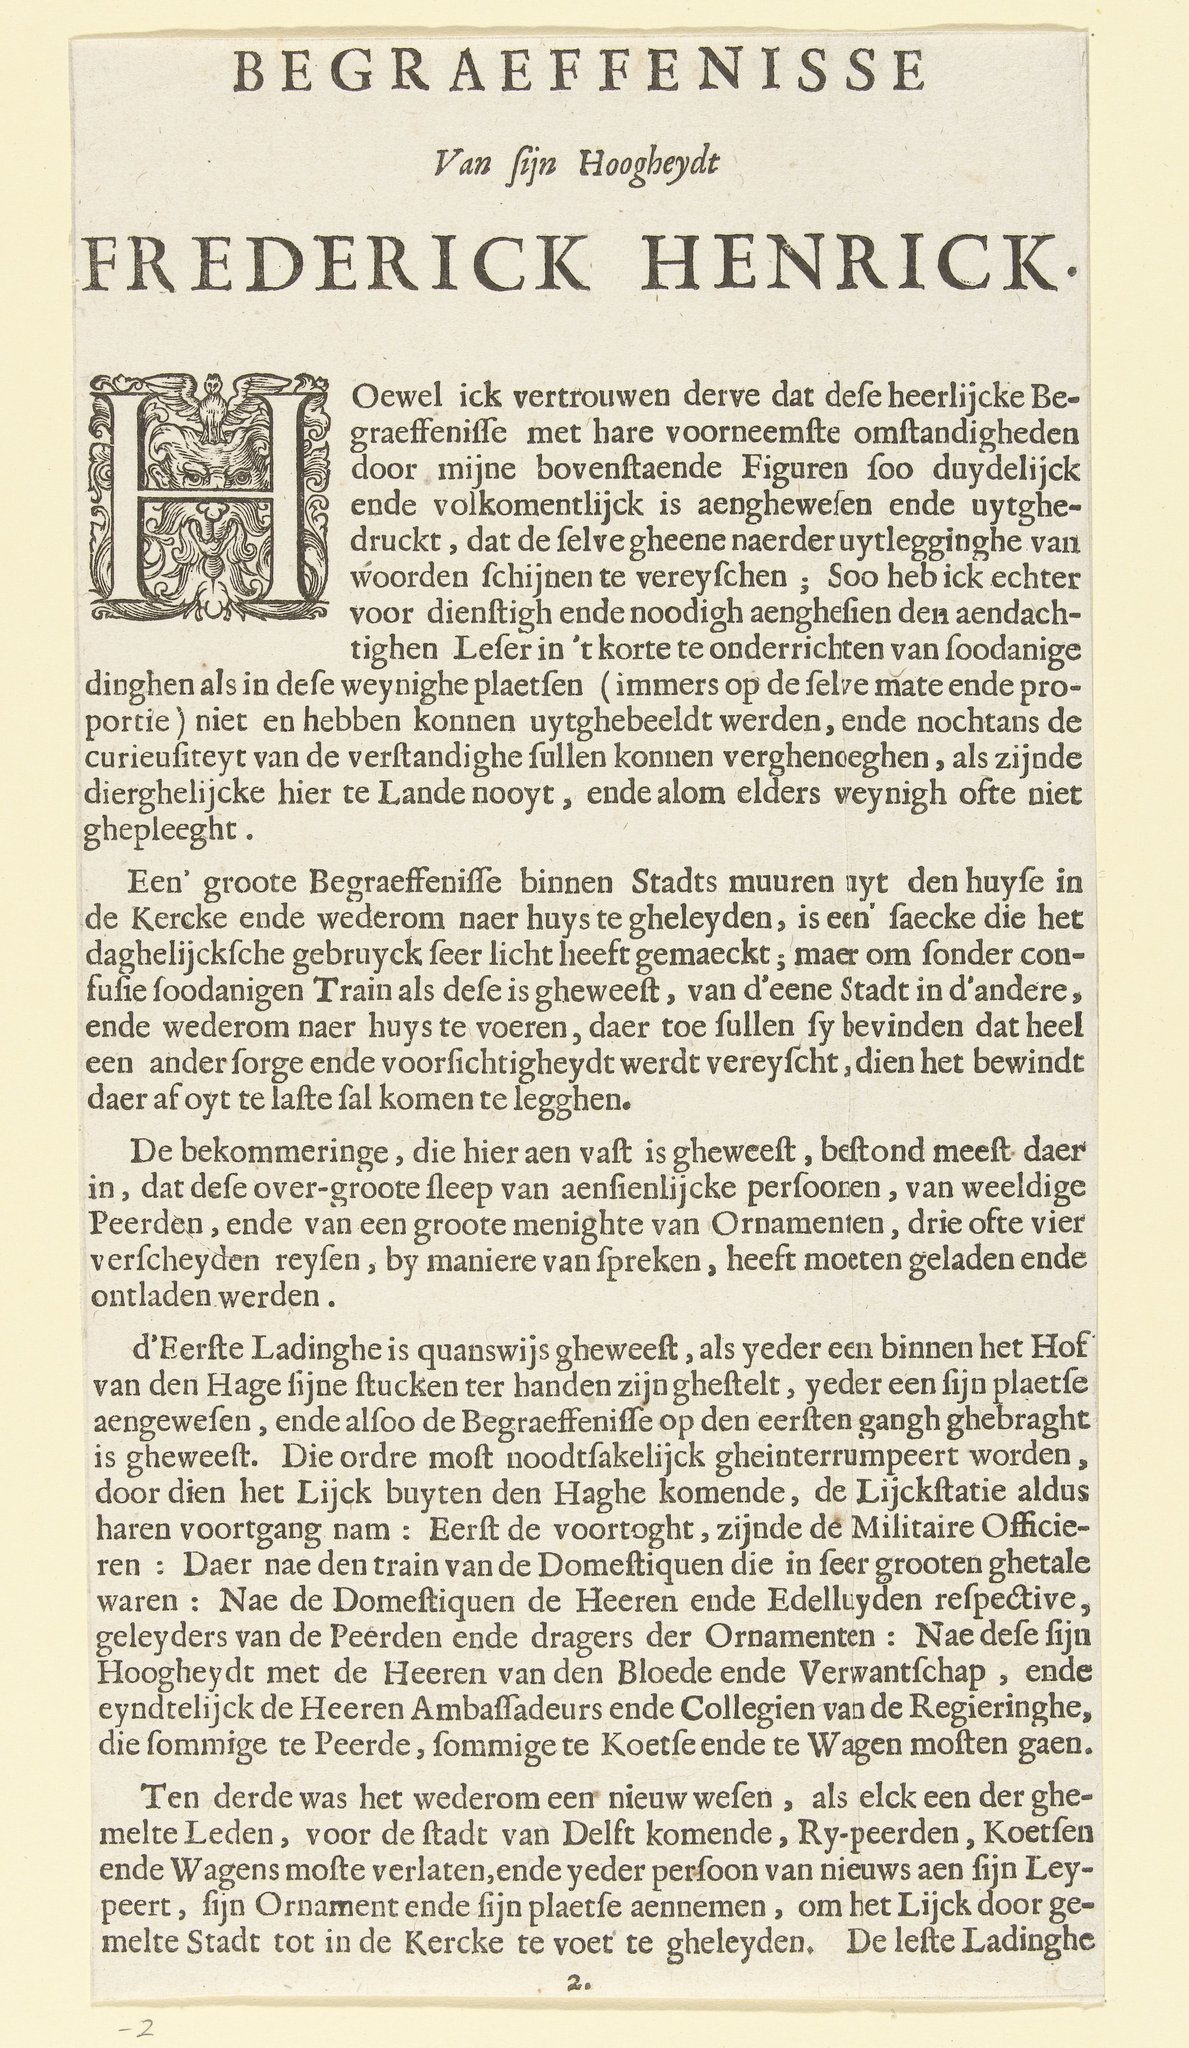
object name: text sheet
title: De begrafenisstoet van stadhouder Frederik Hendrik te 's-Gravenhage in 1647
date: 1651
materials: paper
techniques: letterpress printing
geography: the hague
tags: delft, frederick henry (prince of orange), the hague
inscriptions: collector's mark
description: Tekstblad nr. 2 bij de prentserie van de begrafenisstoet van stadhouder Frederik Hendrik te 's-Gravenhage op 10 mei 1647. Onderdeel van een serie van 30 platen en 20 tekstbladen, bedoeld om aan elkaar geplakt te worden.